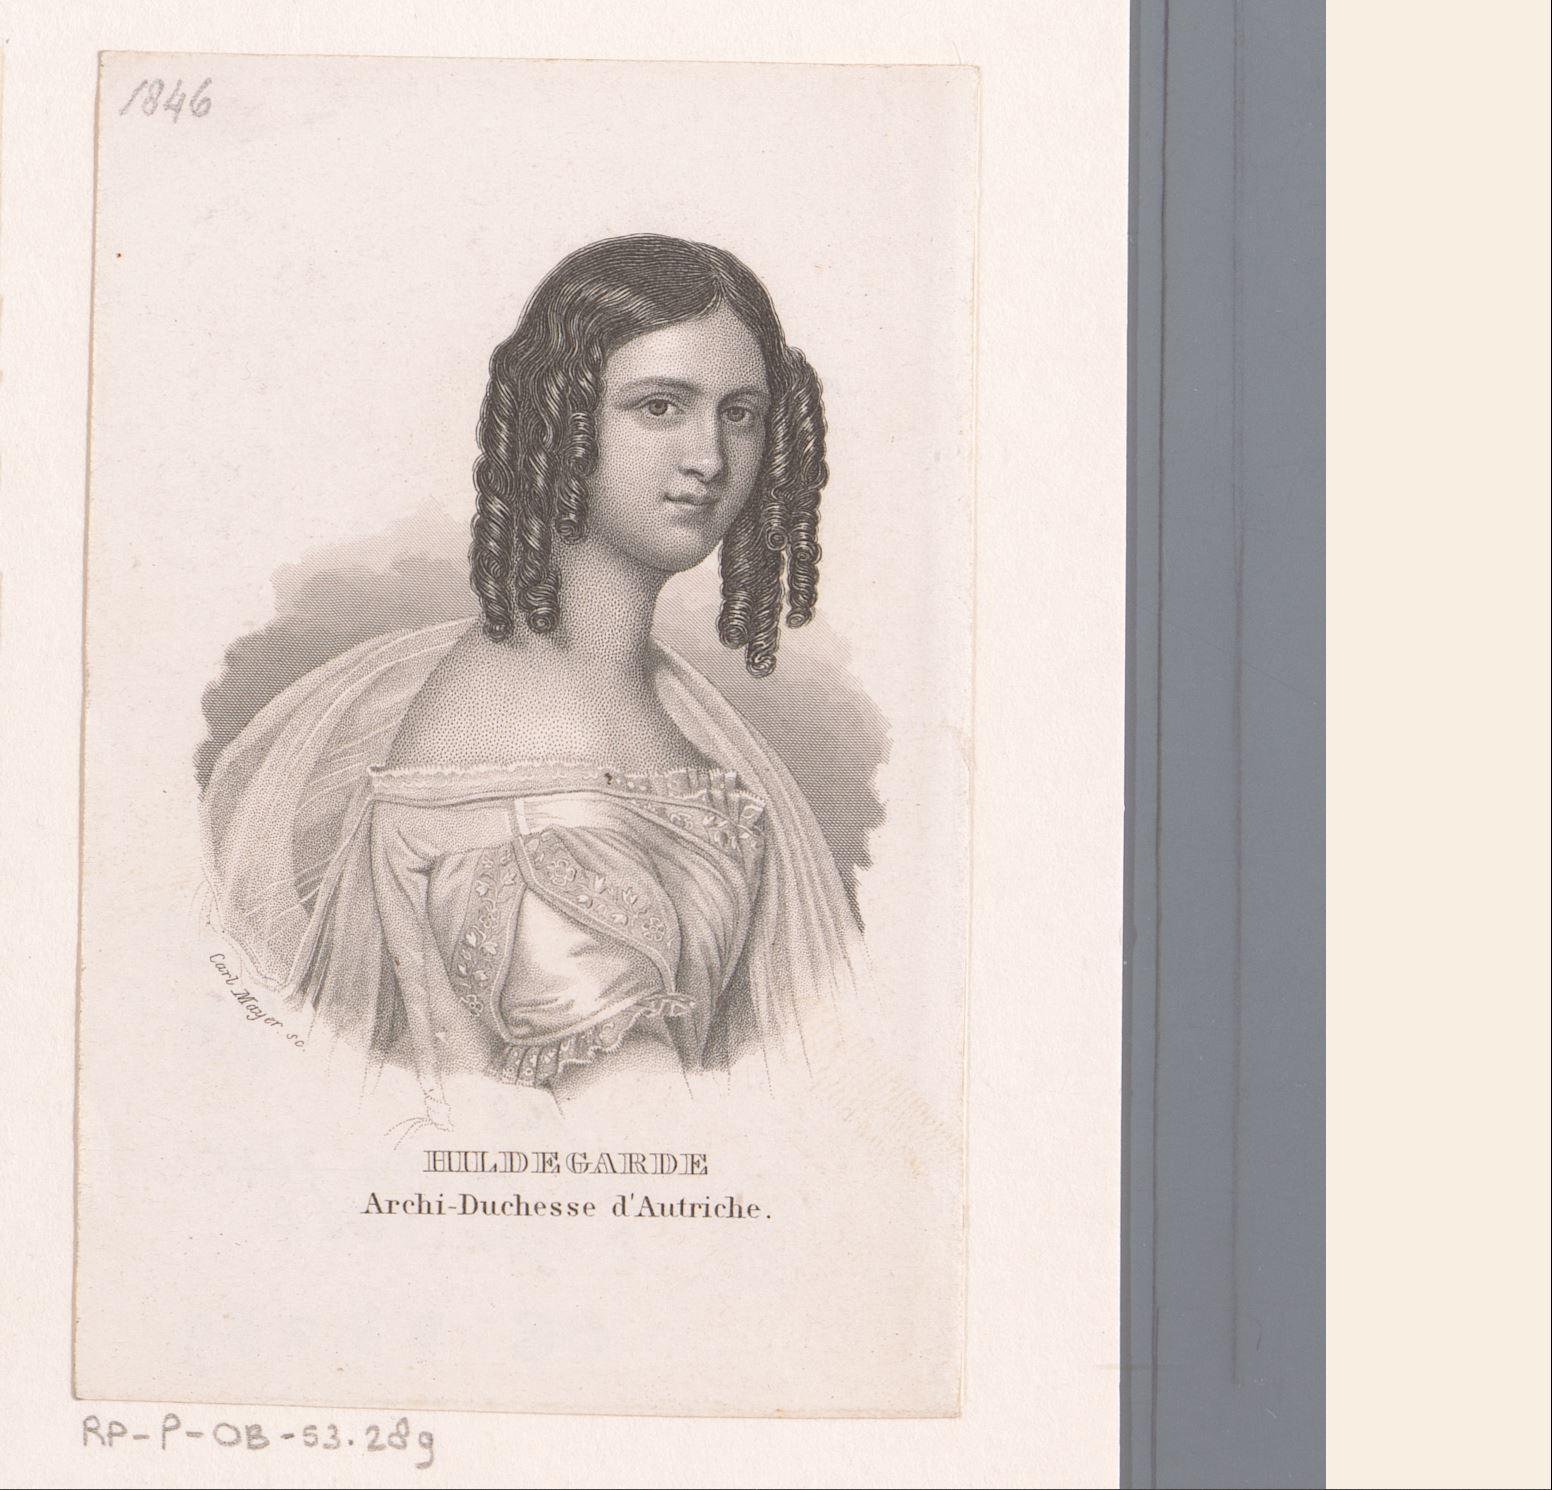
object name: print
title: Portret van Hildegard van Beieren, aartshertogin van Oostenrijk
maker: carl mayer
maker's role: print maker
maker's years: 1798-1868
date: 1825-1868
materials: paper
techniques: engraving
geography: nuremberg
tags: historical persons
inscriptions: collector's mark: Lugt 2228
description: Vermoedelijk afkomstig uit: Almanach de Gotha.